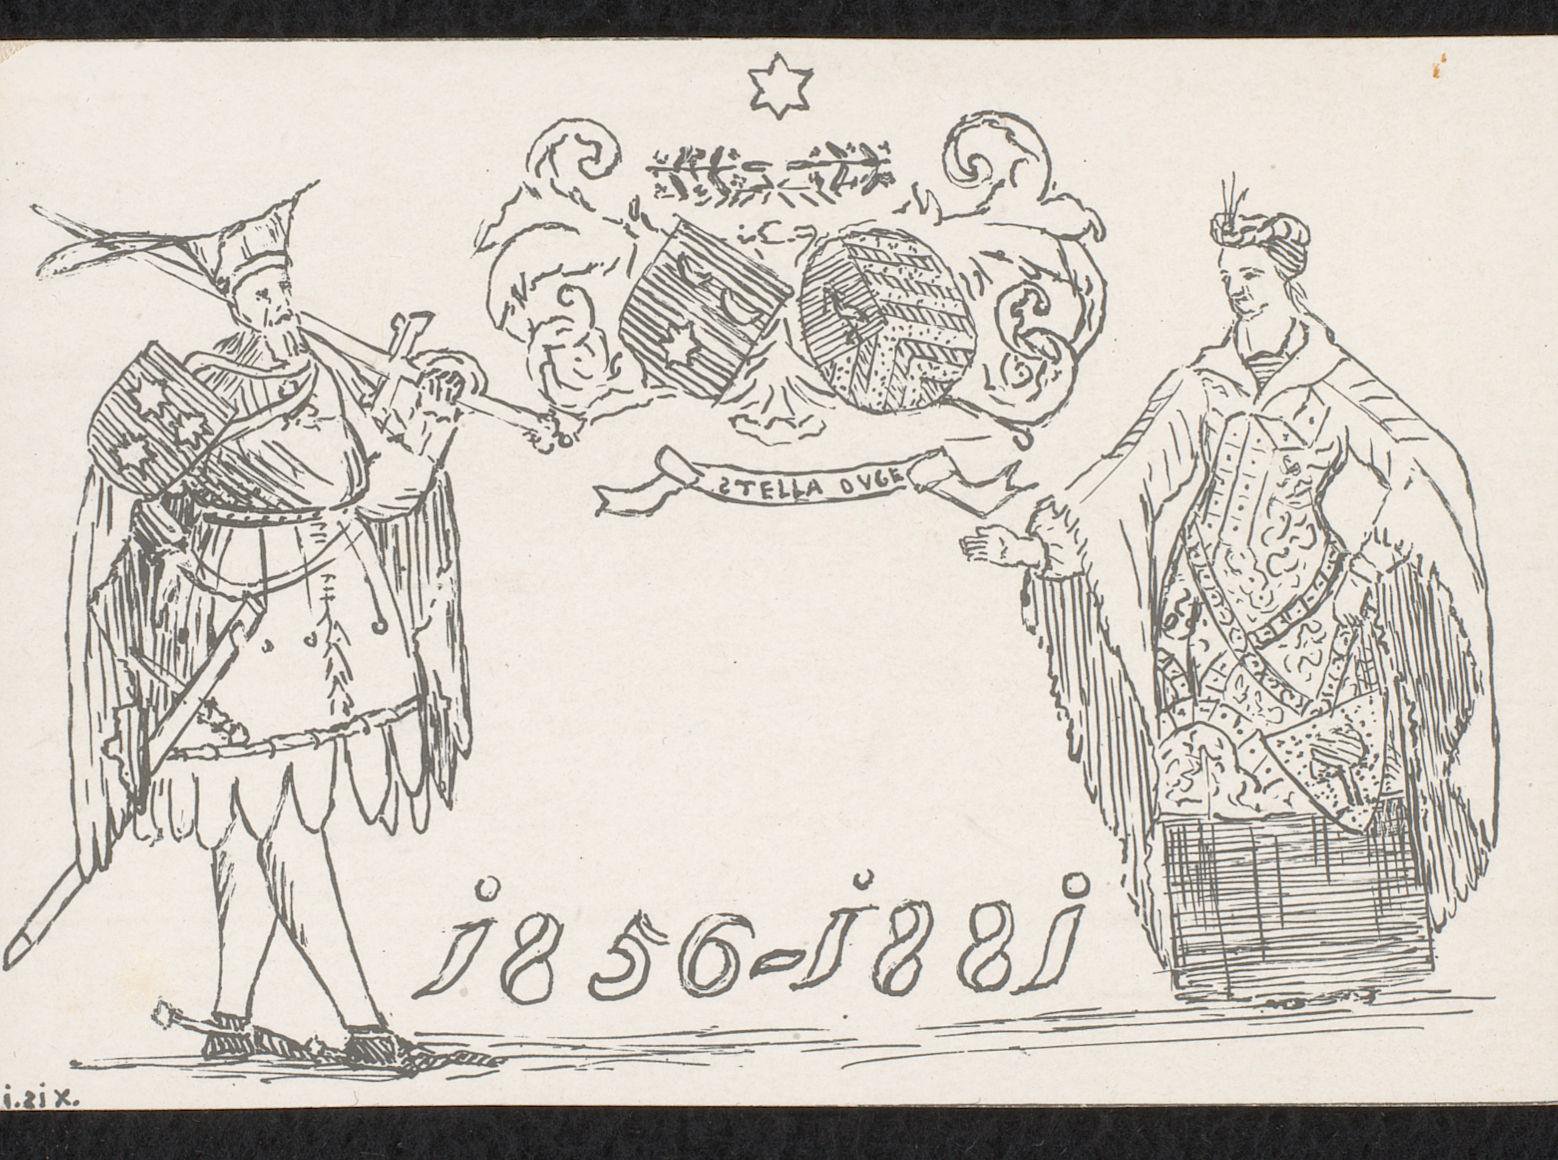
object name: photomechanical print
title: Man en vrouw in middeleeuwse kleding, met daartussen twee familiewapens met daaronder de spreuk 'Stella duce'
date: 1881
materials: paper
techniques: printing block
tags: historical costume, armorial bearing, heraldry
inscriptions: date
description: Hierbij de jaartallen '1856-1881', dus waarschijnlijk een herdenkings- of jubileumprent.